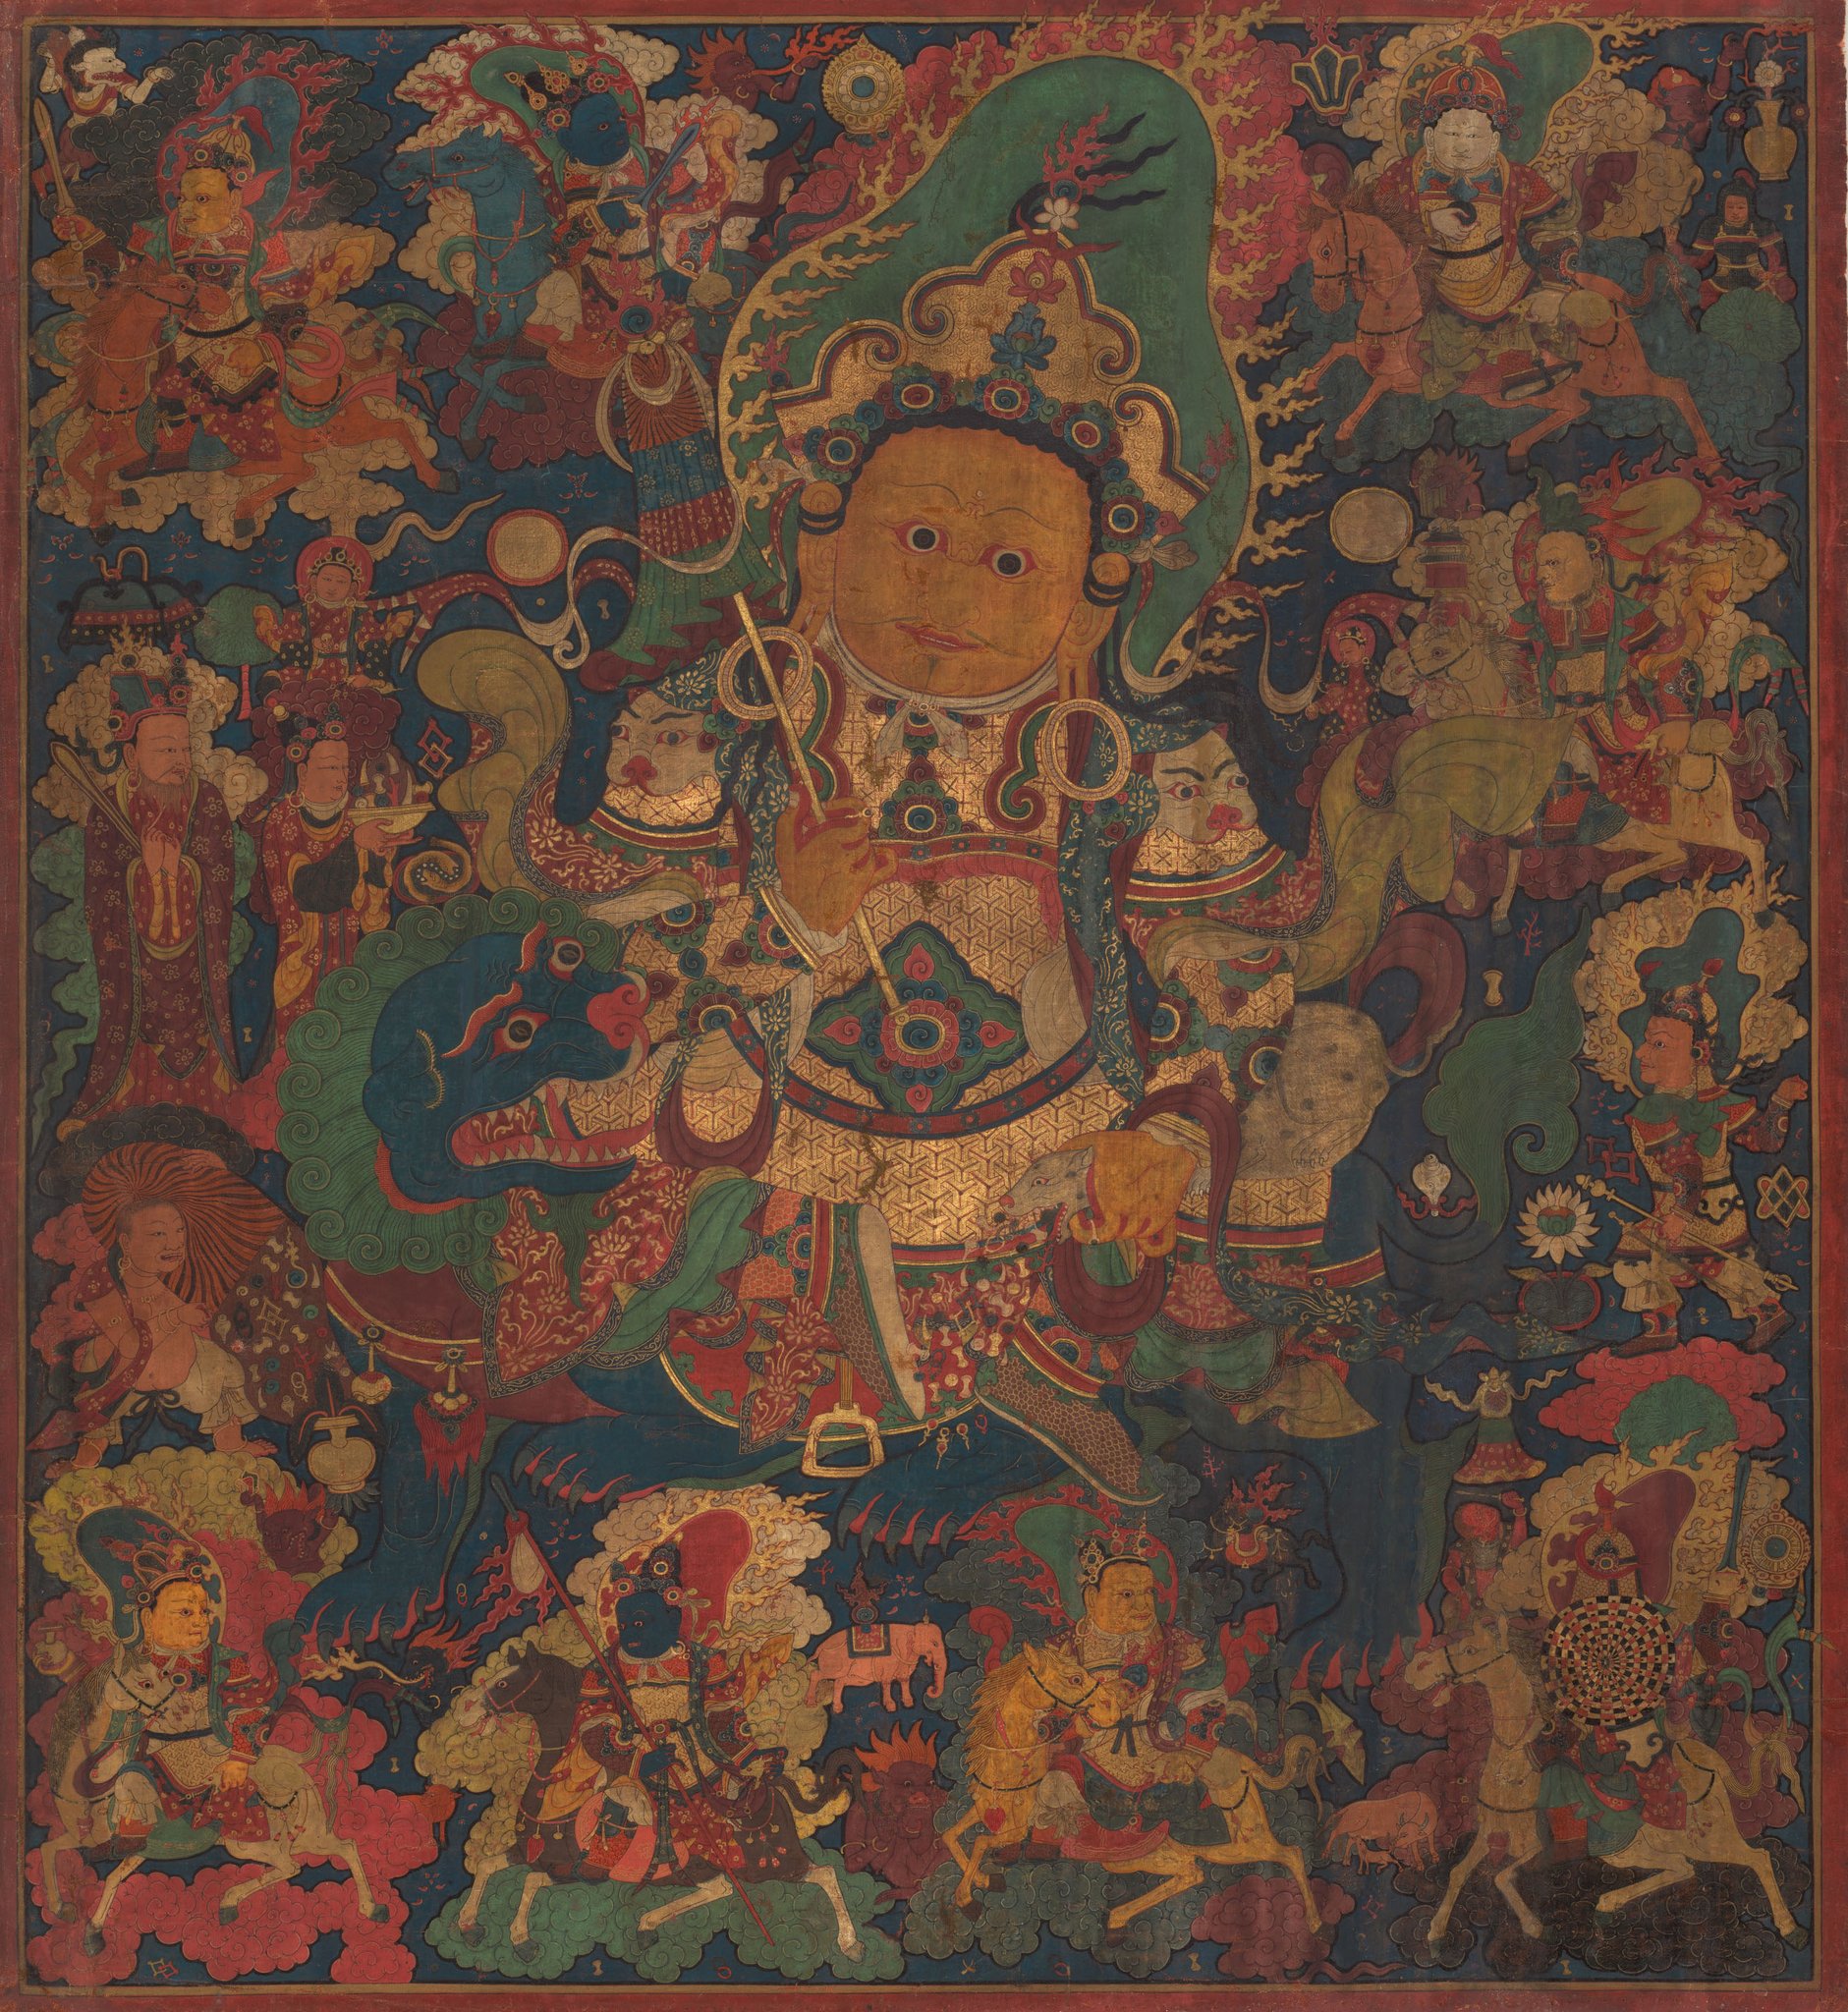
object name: thangka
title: Vaishravana, Guardian of Buddhism and Protector of Riches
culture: tibetan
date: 1401-1500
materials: textile